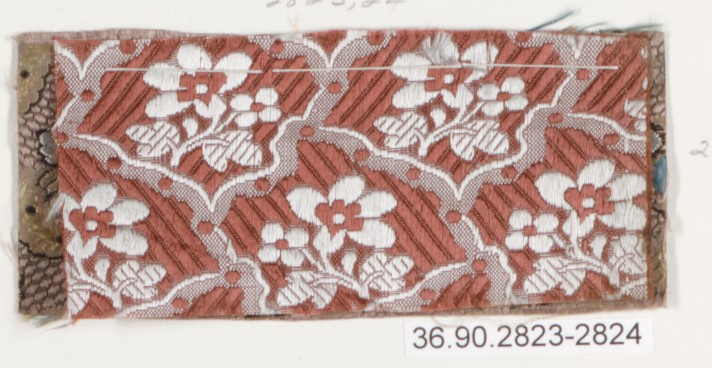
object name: piece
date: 1801-1900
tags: flowers